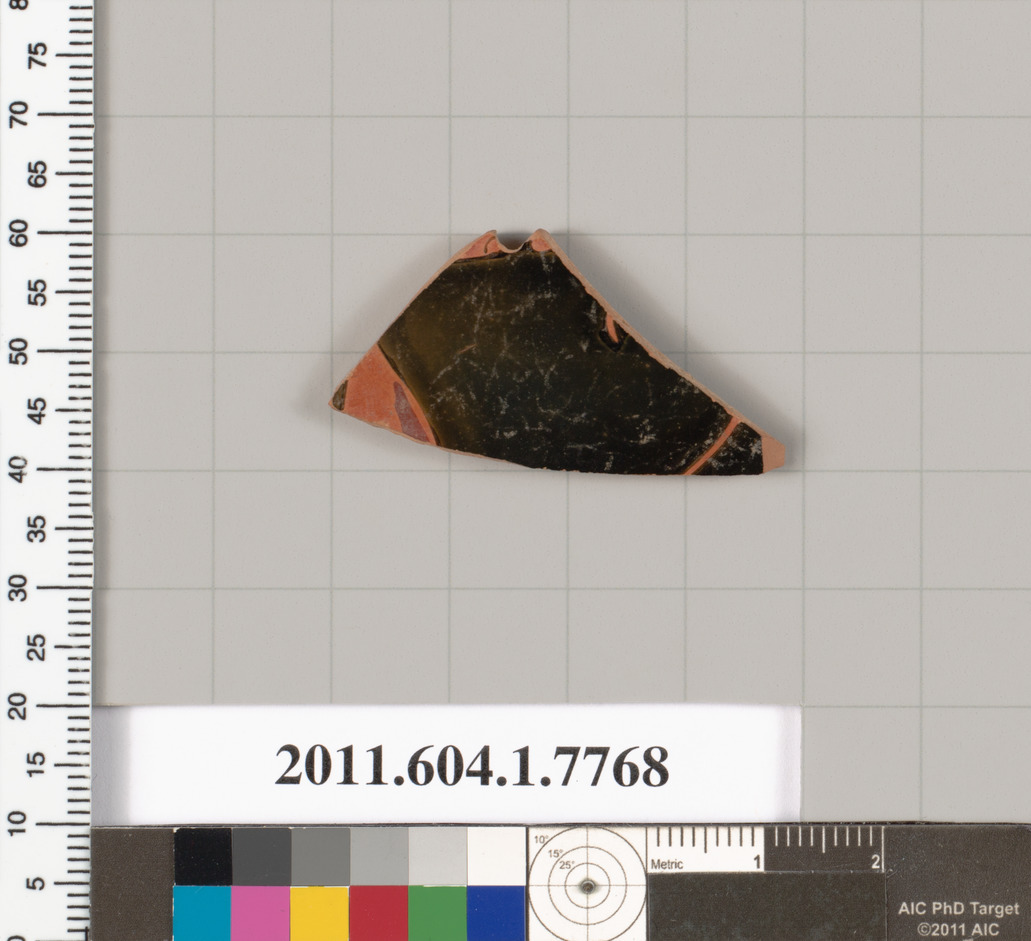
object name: kylix fragment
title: Terracotta fragment of a kylix (drinking cup)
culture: greek, attic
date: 460-450 BCE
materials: terracotta